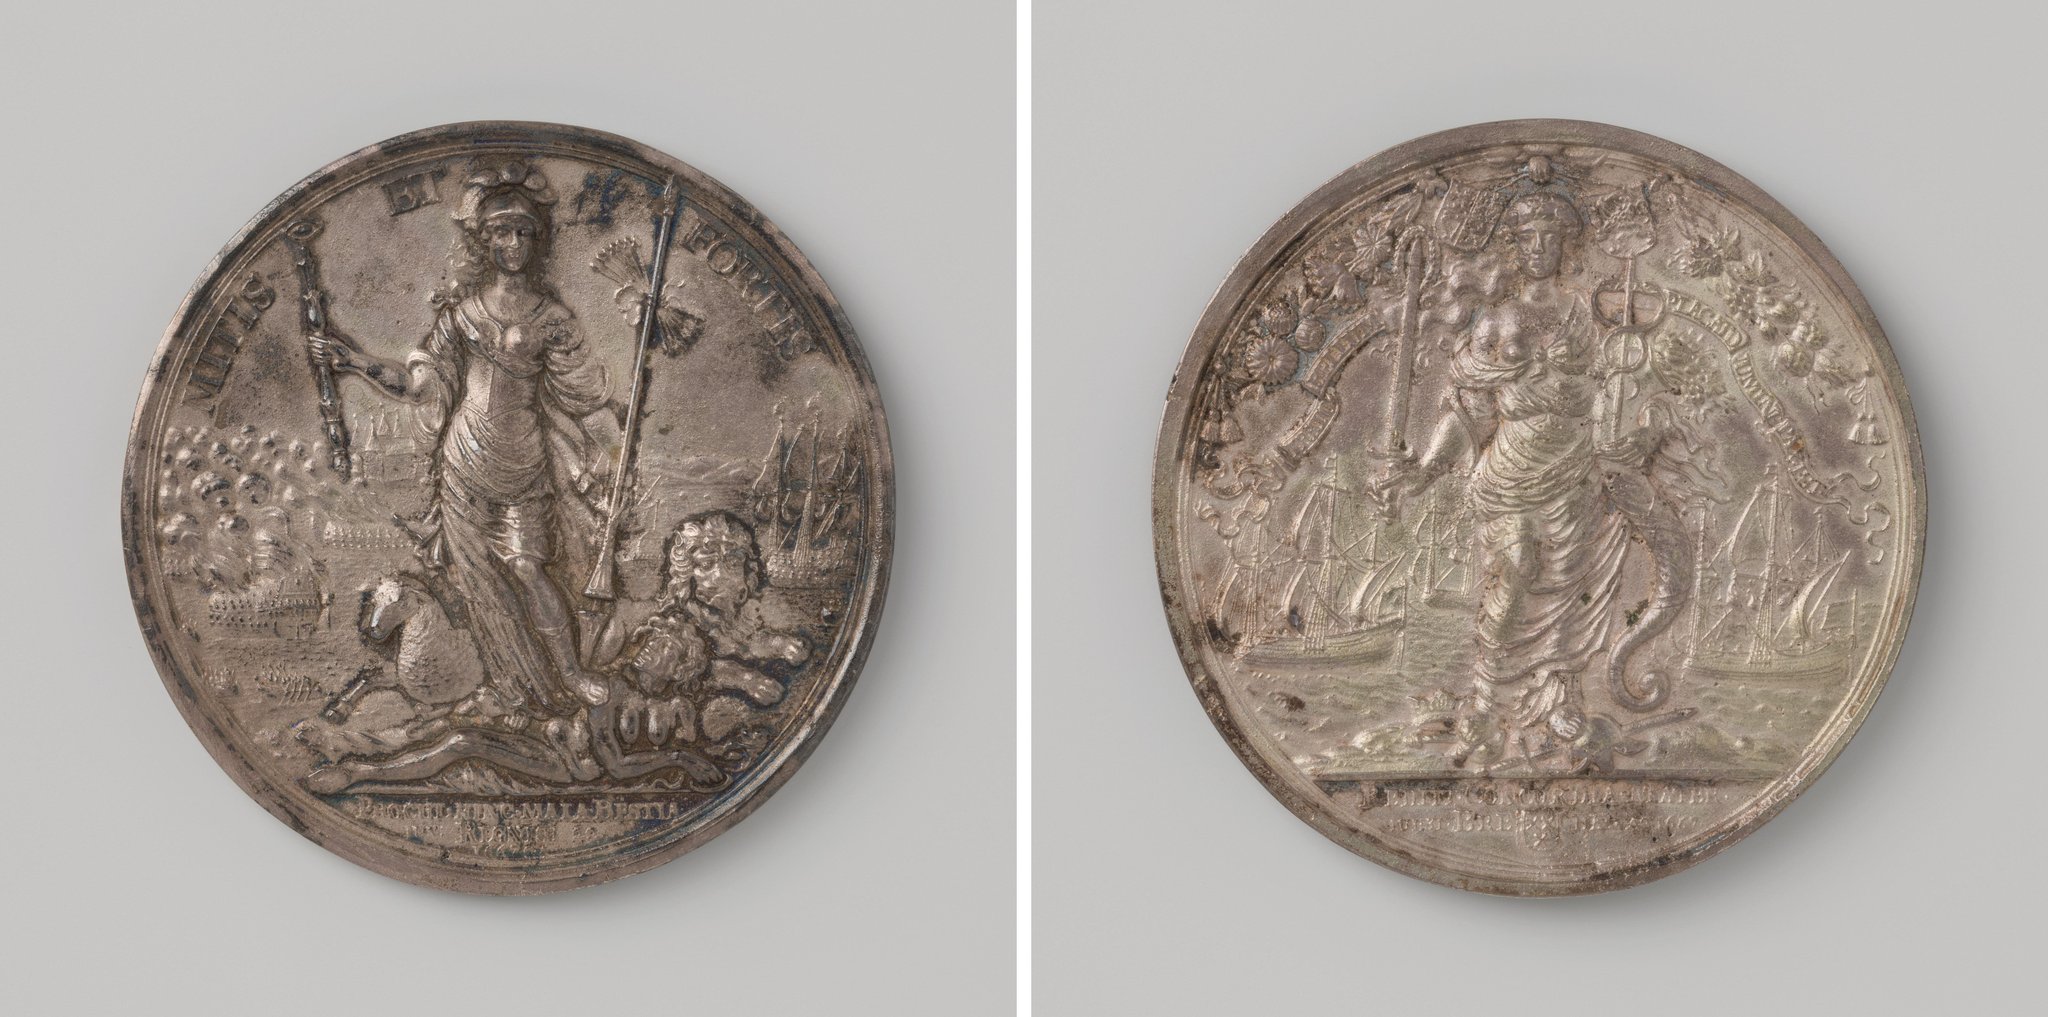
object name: history medal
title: Vrede van Breda 1667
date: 1667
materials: brass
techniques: casting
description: Zilverkleurige penning, op de voorzijde de Nederlandse Maagd met scepter en piek die de Afgunst vertreedt, tussen schaap en leeuw, op de achtergrond de vernietiging van de Engelse vloot bij Chatham, met omschrift en afsnedetekst, op de keerzijde de Nederlandse Maagd met gelauwerd zwaard, mercuriusstaf en hoorn des overvloeds die wapentuig vertreedt, op de achtergrond koopvaardijschepen, bovenaan het Engelse en Nederlandse wapenschild in Gods hand te midden van bloemenslingers en een lint met opschrift, met afsnedetekst.